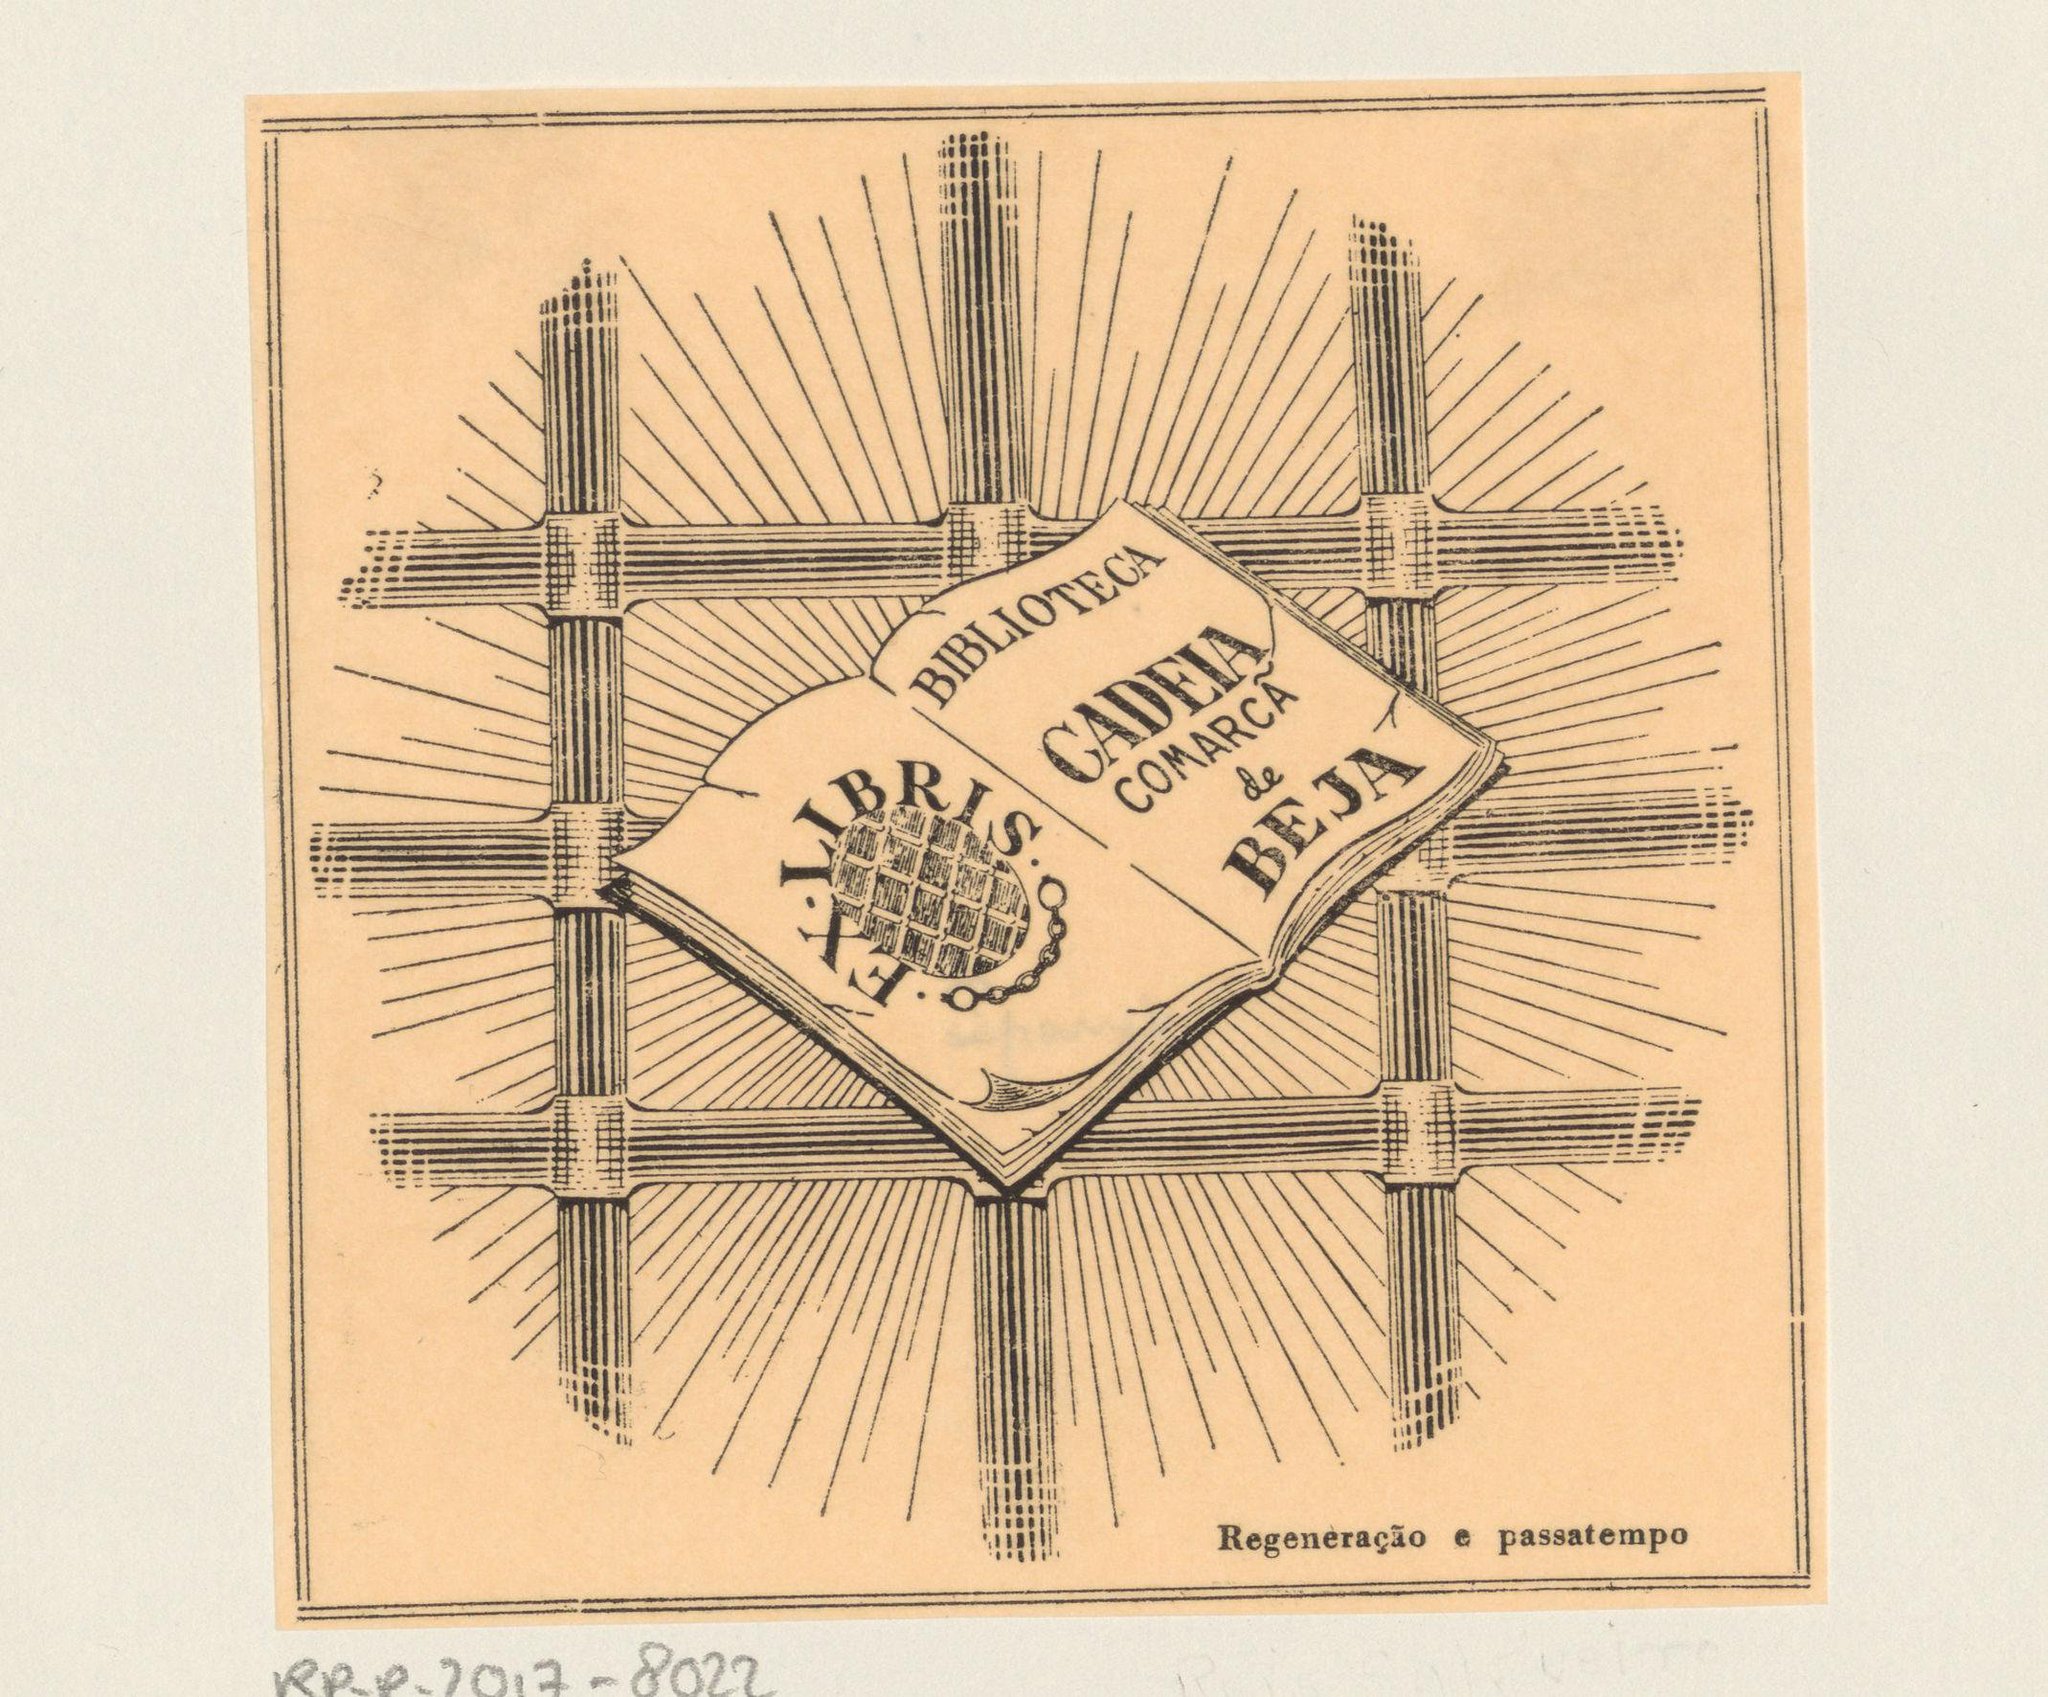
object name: bookplate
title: Ex libris van de bibliotheek van de gemeente Beja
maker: Anonymous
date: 1952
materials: paper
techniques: printing block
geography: portugal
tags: book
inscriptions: date